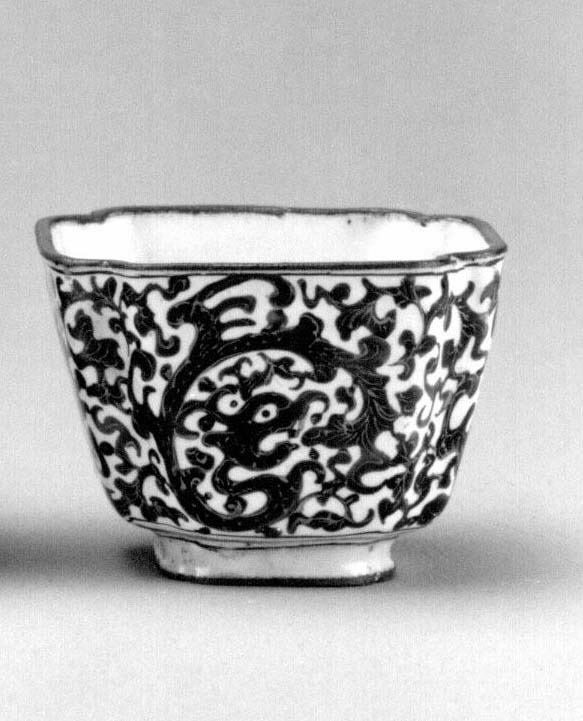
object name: cup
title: Square Cup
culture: chinese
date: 1801-1900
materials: enamel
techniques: painting